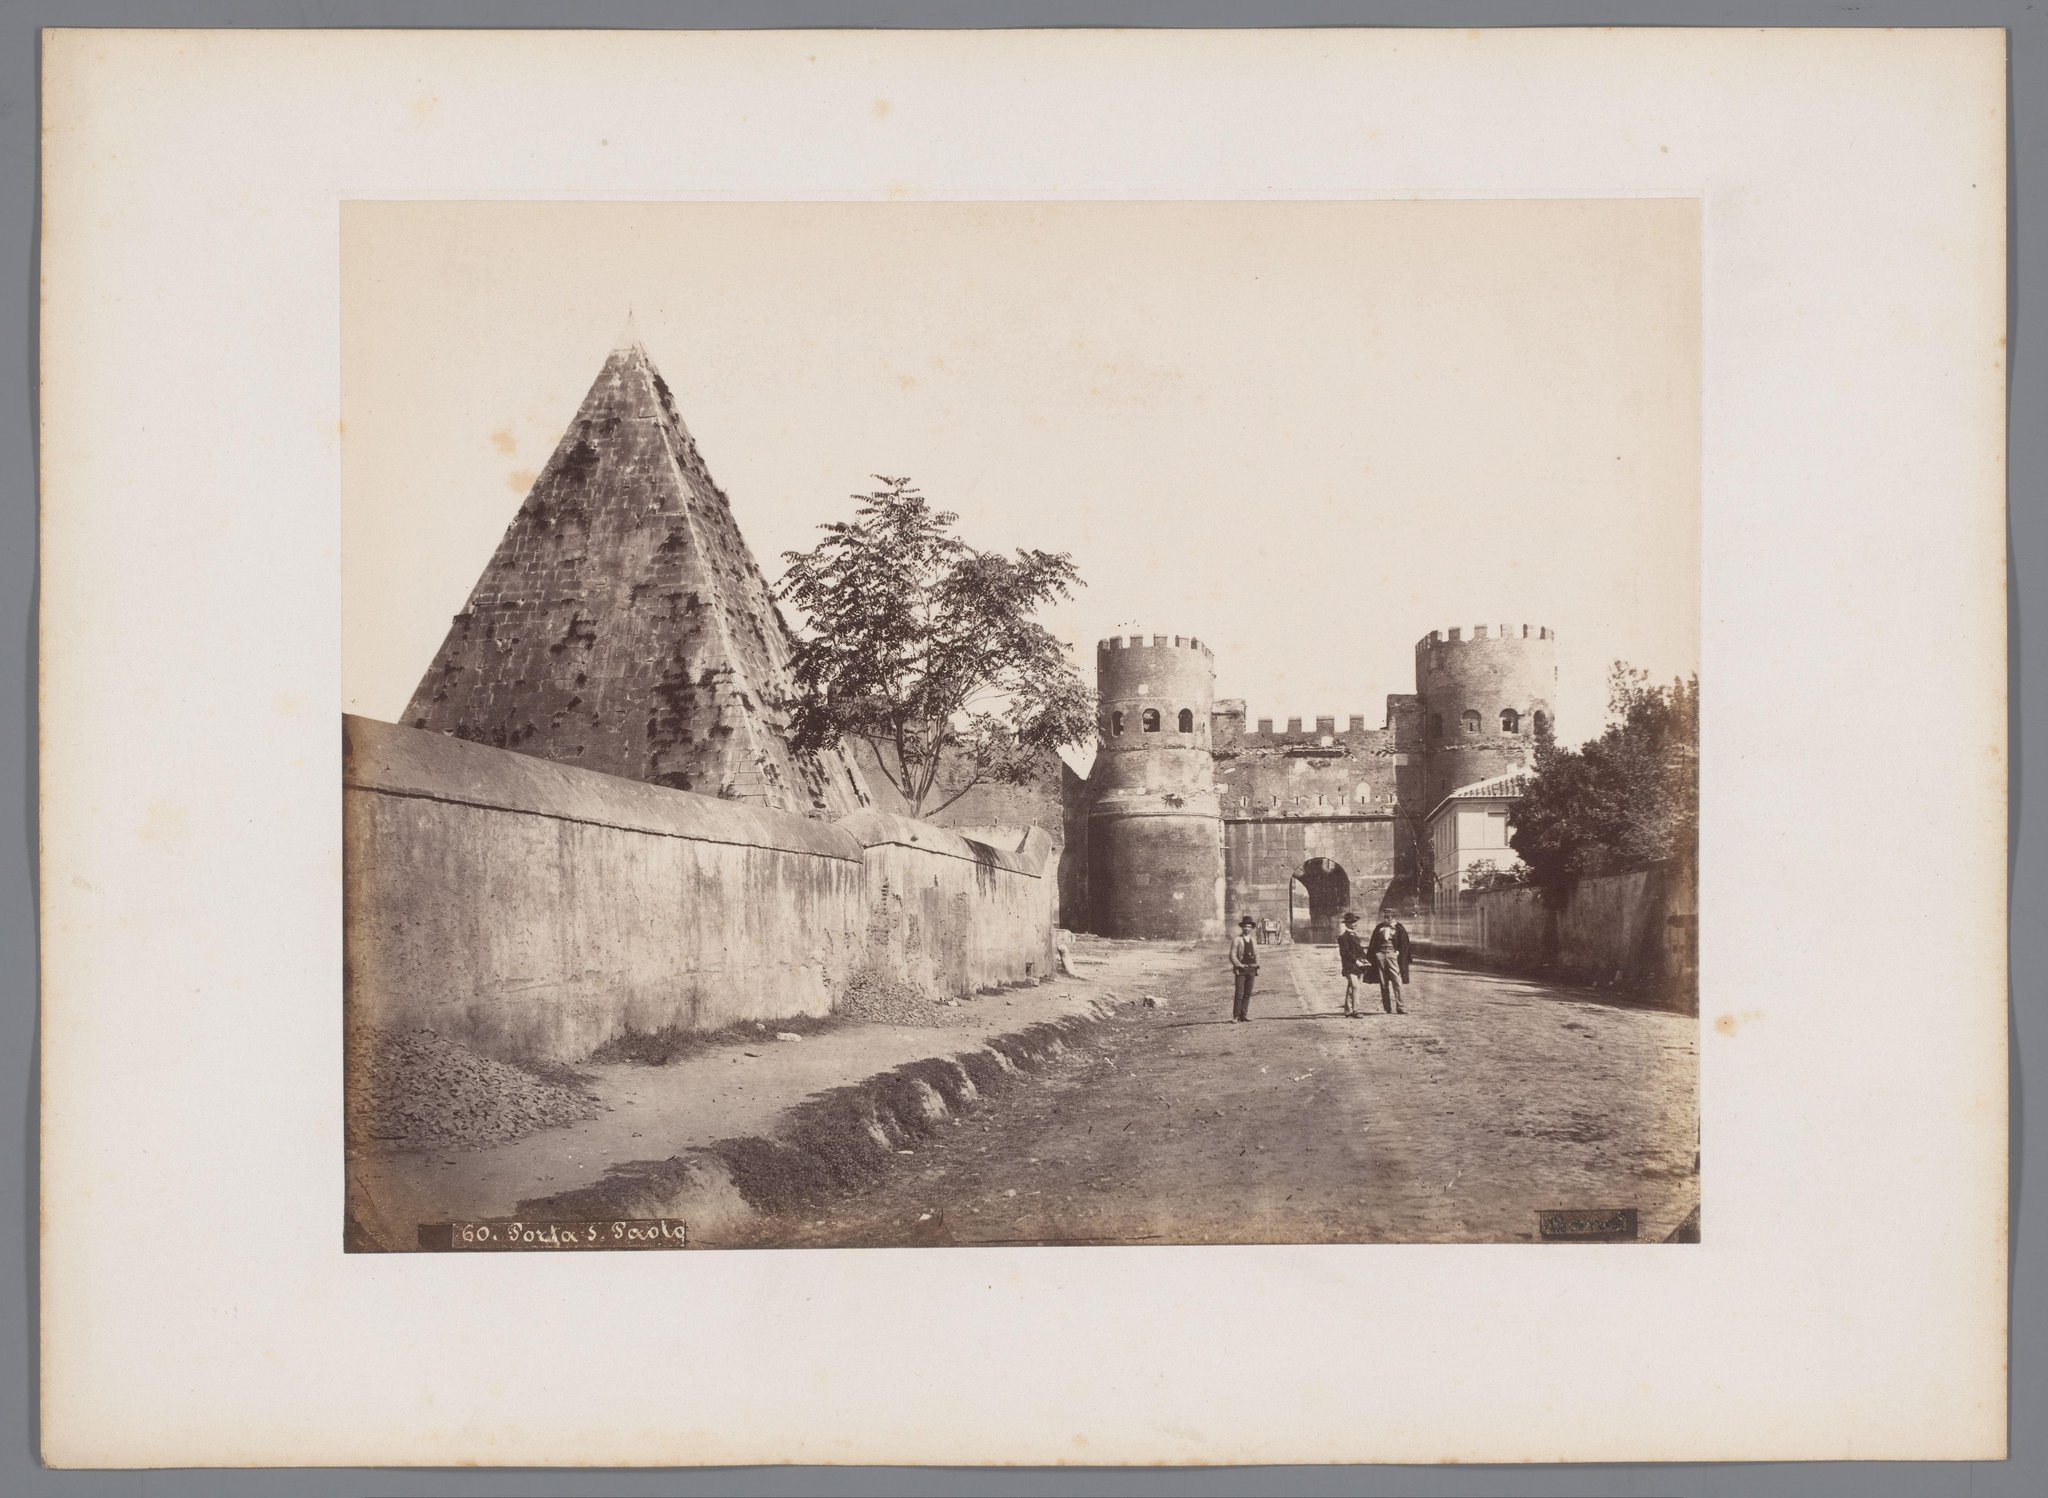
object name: photograph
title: Gezicht op de Porta San Paolo en de Piramide van Cestius te Rome, Italië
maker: Anonymous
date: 1851-1900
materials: cardboard, paper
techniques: albumen print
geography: rome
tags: pyramid (marking grave), city-gate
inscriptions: number: ‘9’, number: ‘60.’, number: ‘86.’